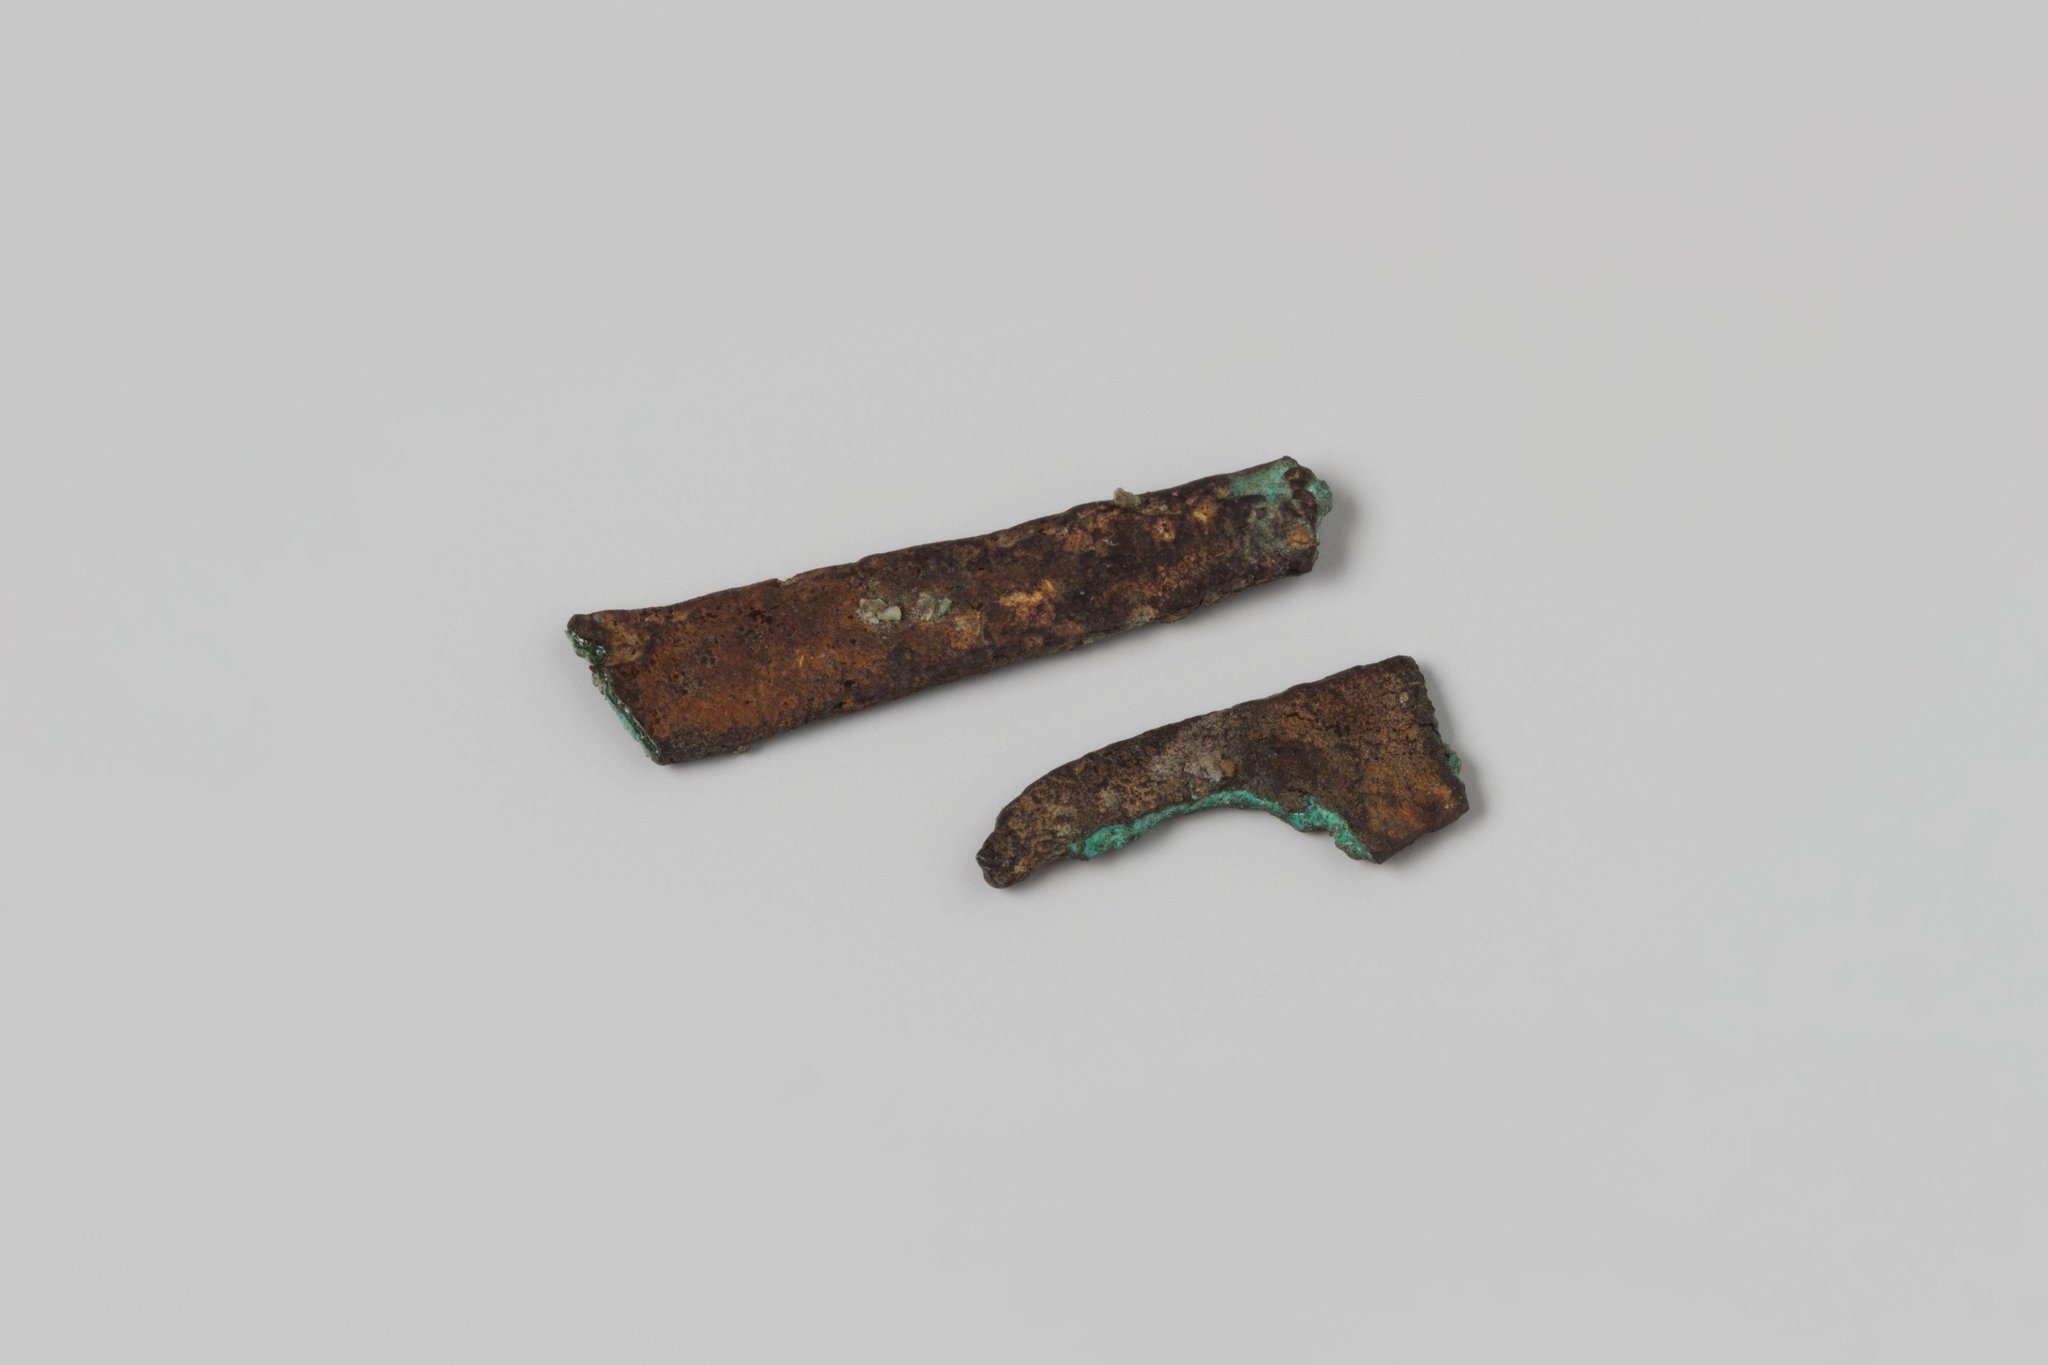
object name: scheepswrakvondst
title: Fragment van koper uit het wrak van de Oost-Indiëvaarder Hollandia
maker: Anonymous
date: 1700-1743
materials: copper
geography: netherlands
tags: verenigde oostindische compagnie, hollandia (schip), annet